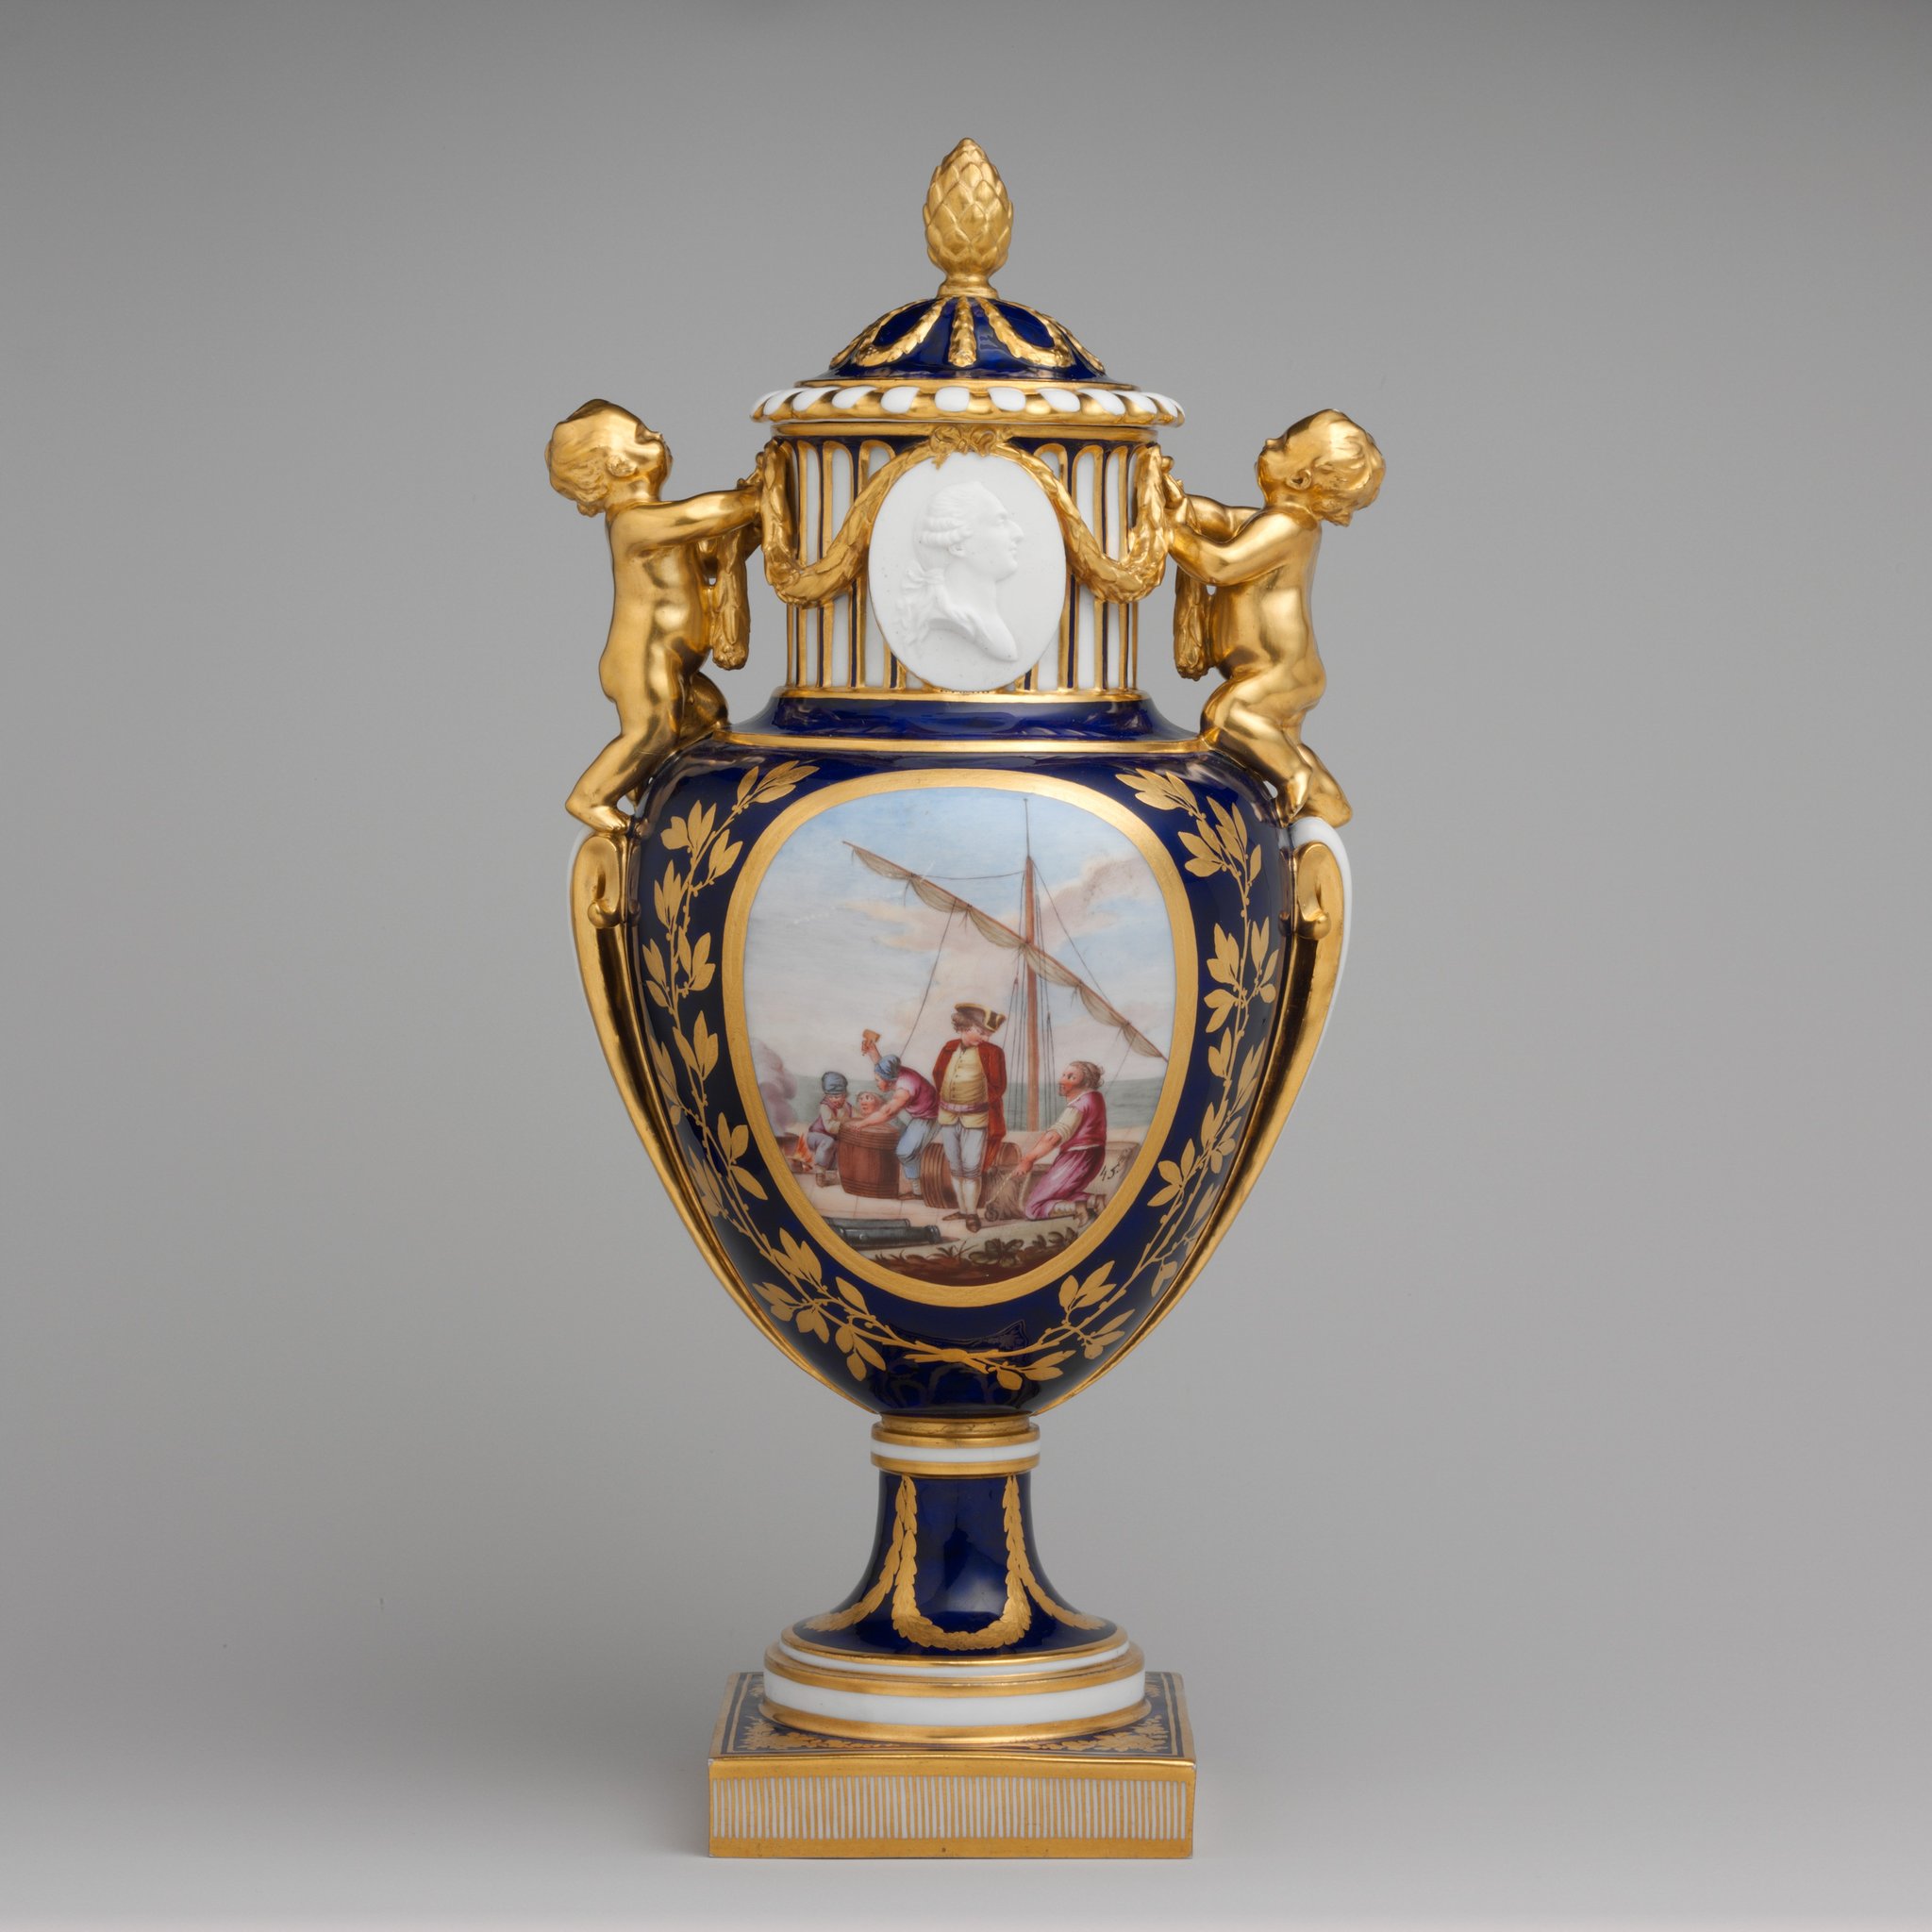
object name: vase with cover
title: Vase with cover (Vase Paris enfants)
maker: sèvres manufactory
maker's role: manufactory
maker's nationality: french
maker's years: 1740-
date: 1778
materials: soft paste porcelain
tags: louis xvi,marie antoinette,men,putti